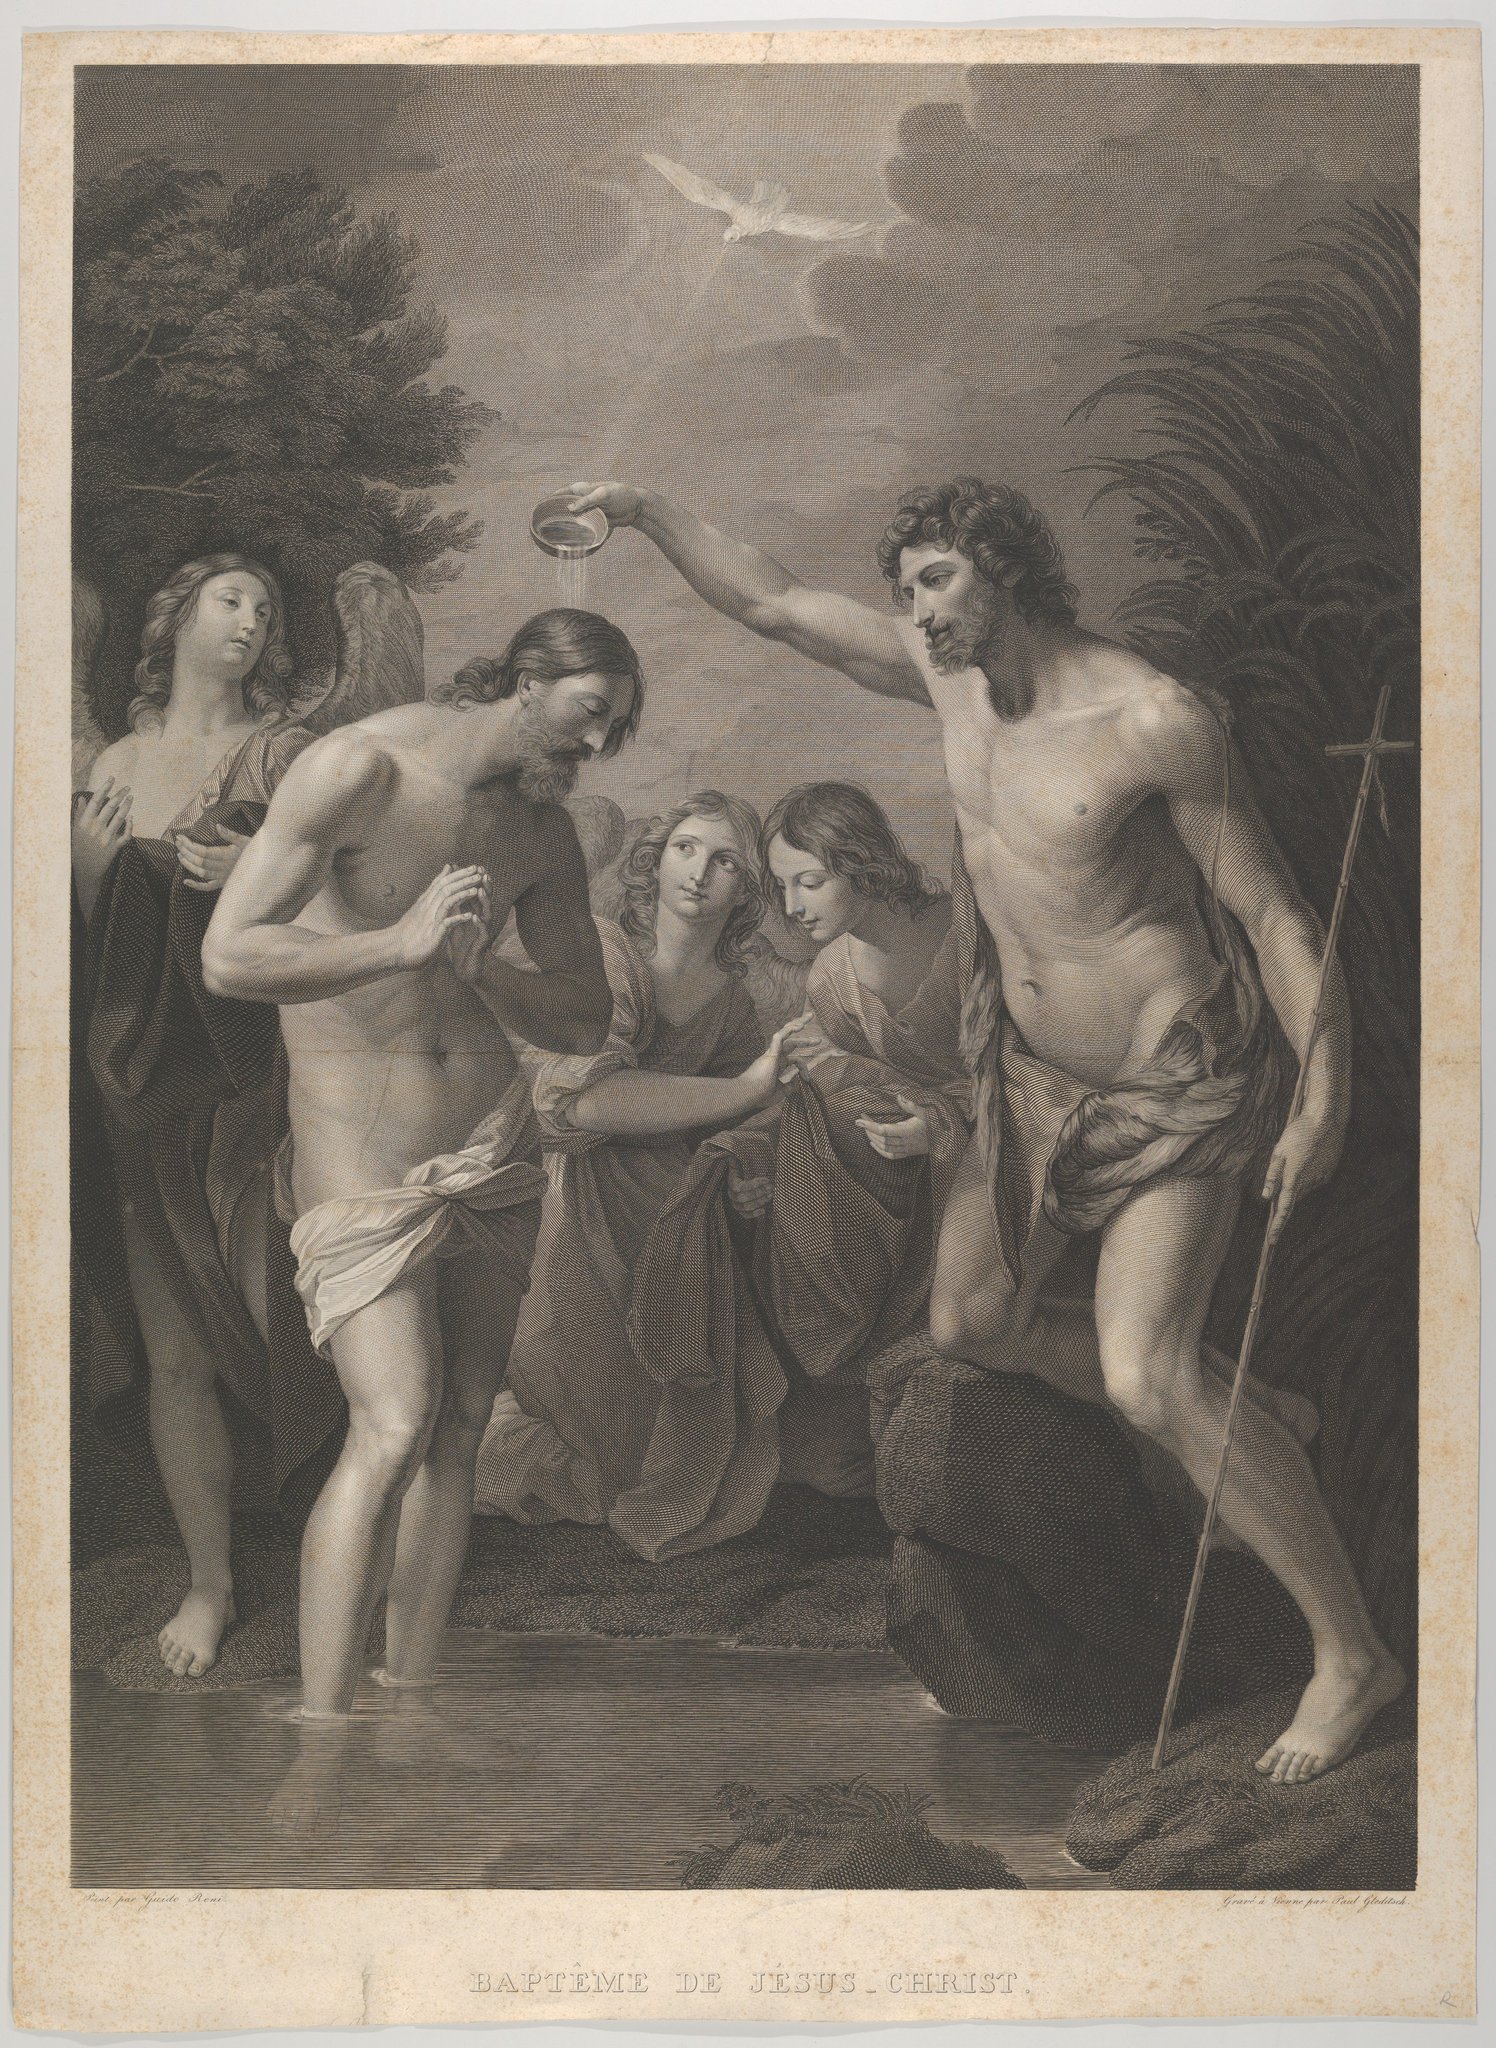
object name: print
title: The Baptism of Christ; Saint John the Baptist at right and Christ at left with his hands held together, the Holy Dove above, angels in the background, after Reni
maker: paul gleditsch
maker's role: artist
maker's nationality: austrian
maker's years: 1793-1872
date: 1815-1872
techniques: engraving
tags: women,angels,christ,baptism of christ